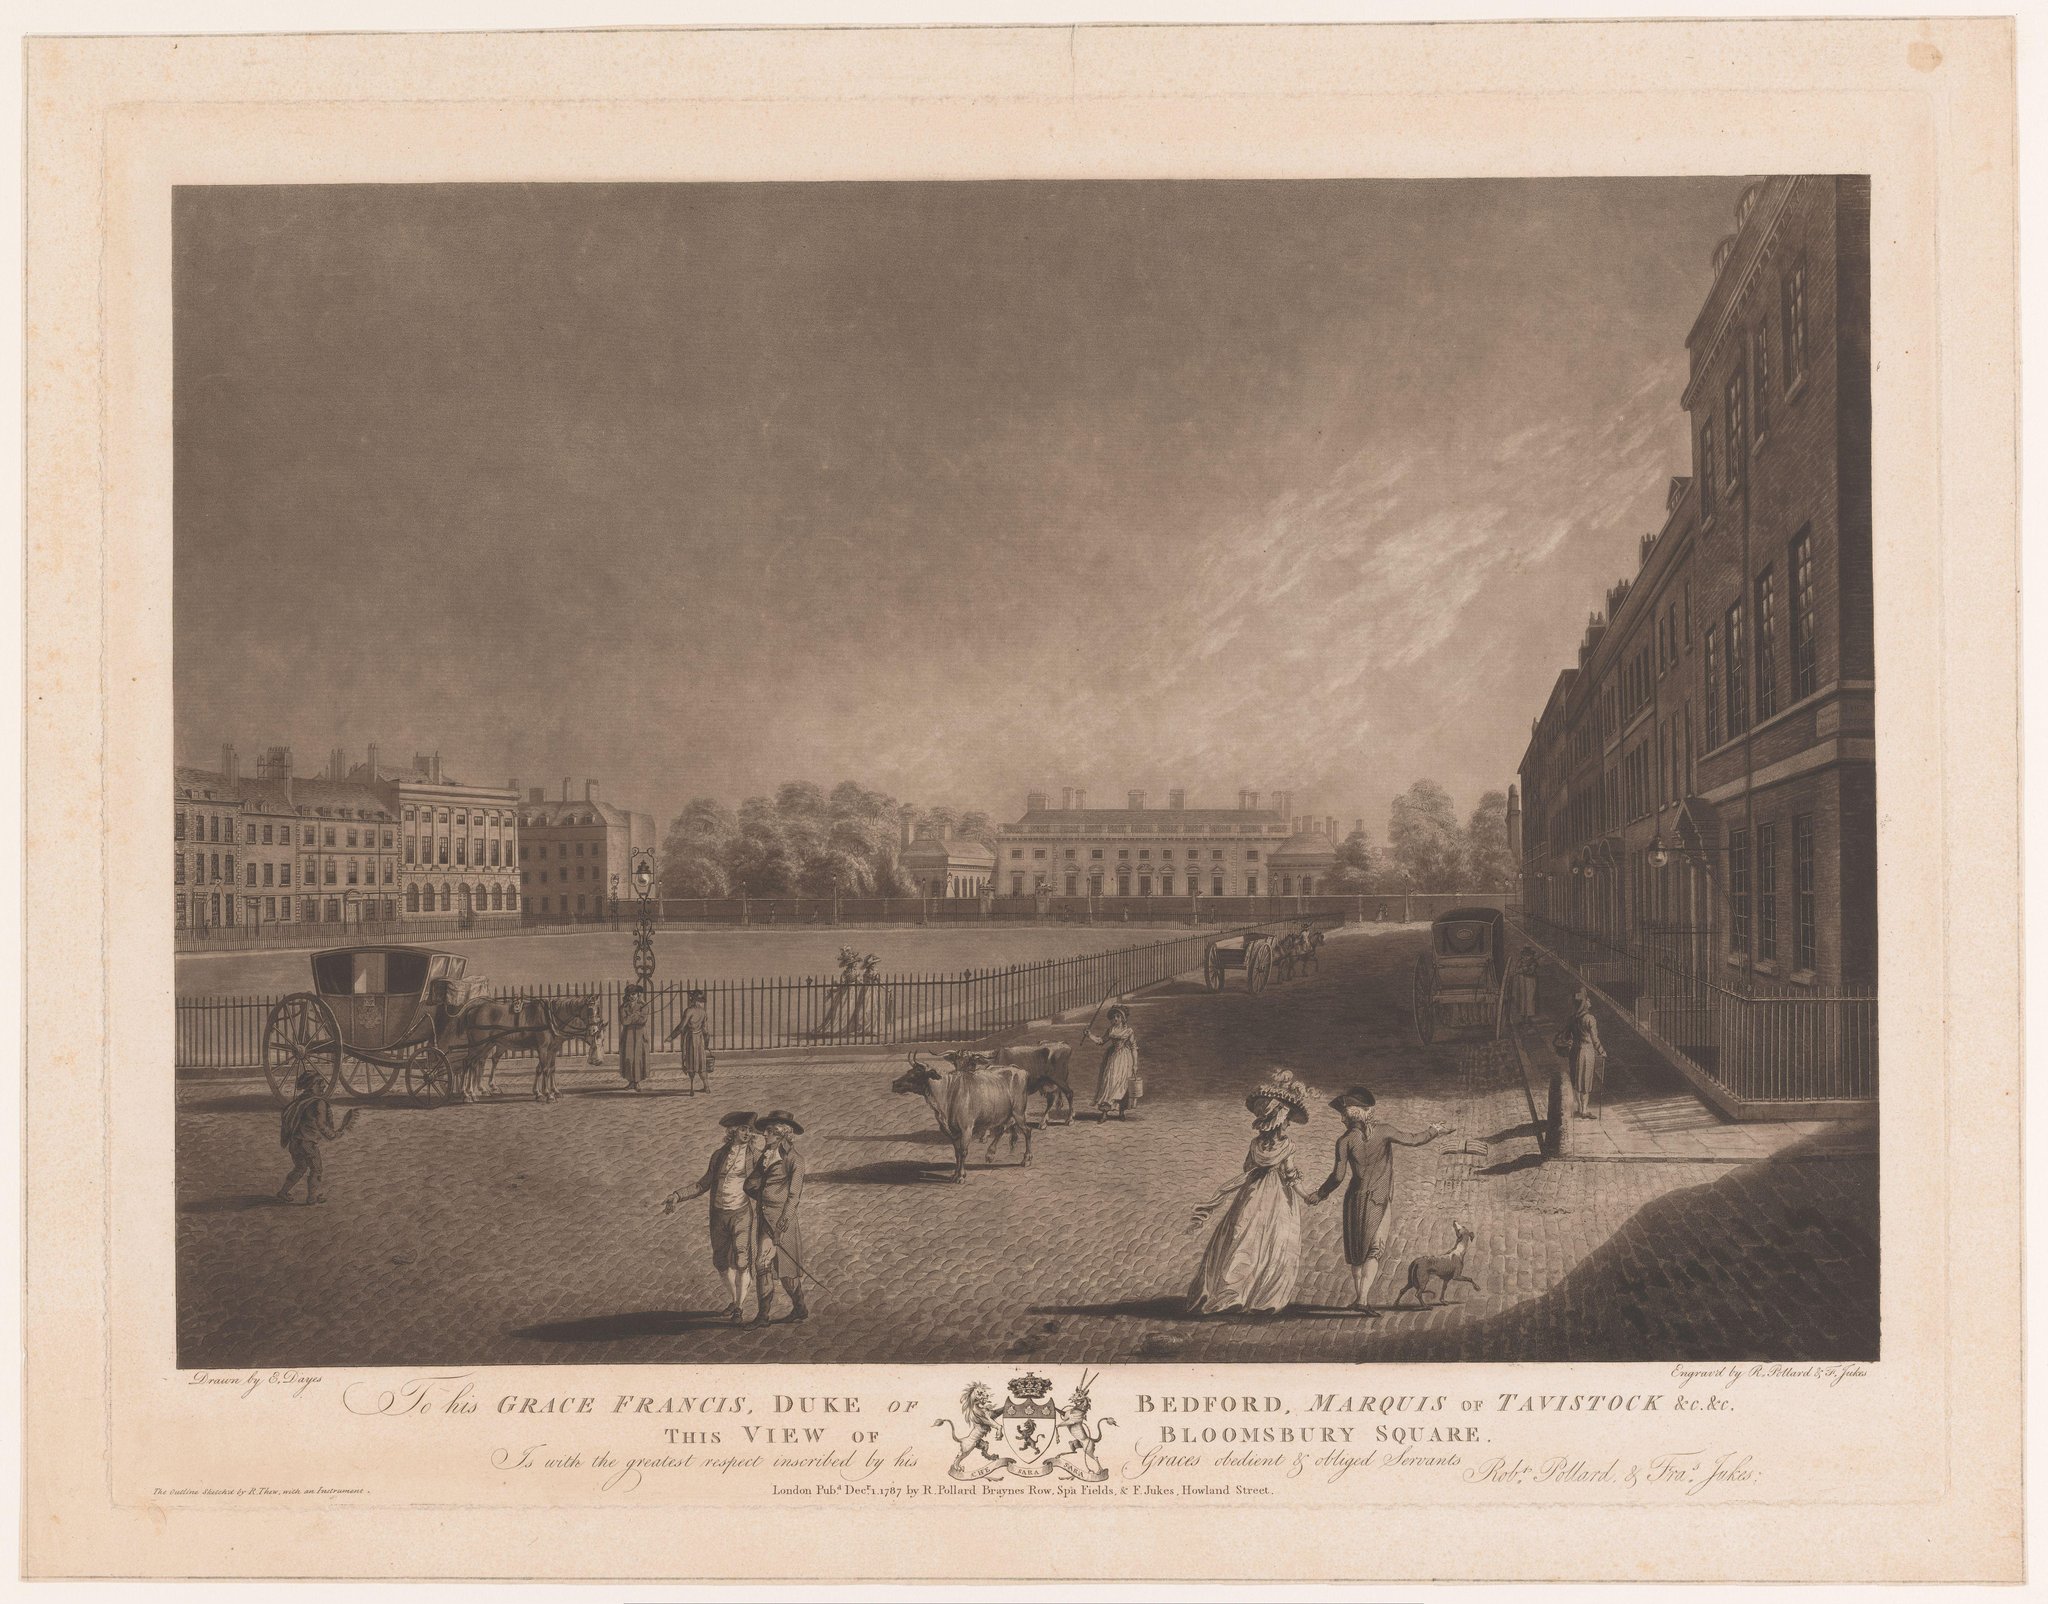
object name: print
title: View of Bloomsbury Square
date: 1712-1787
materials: paper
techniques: aquatint, etching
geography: london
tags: square, place, circus, etc. (+ city(-scape) with figures, staffage)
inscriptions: collector's mark: Lugt 2233